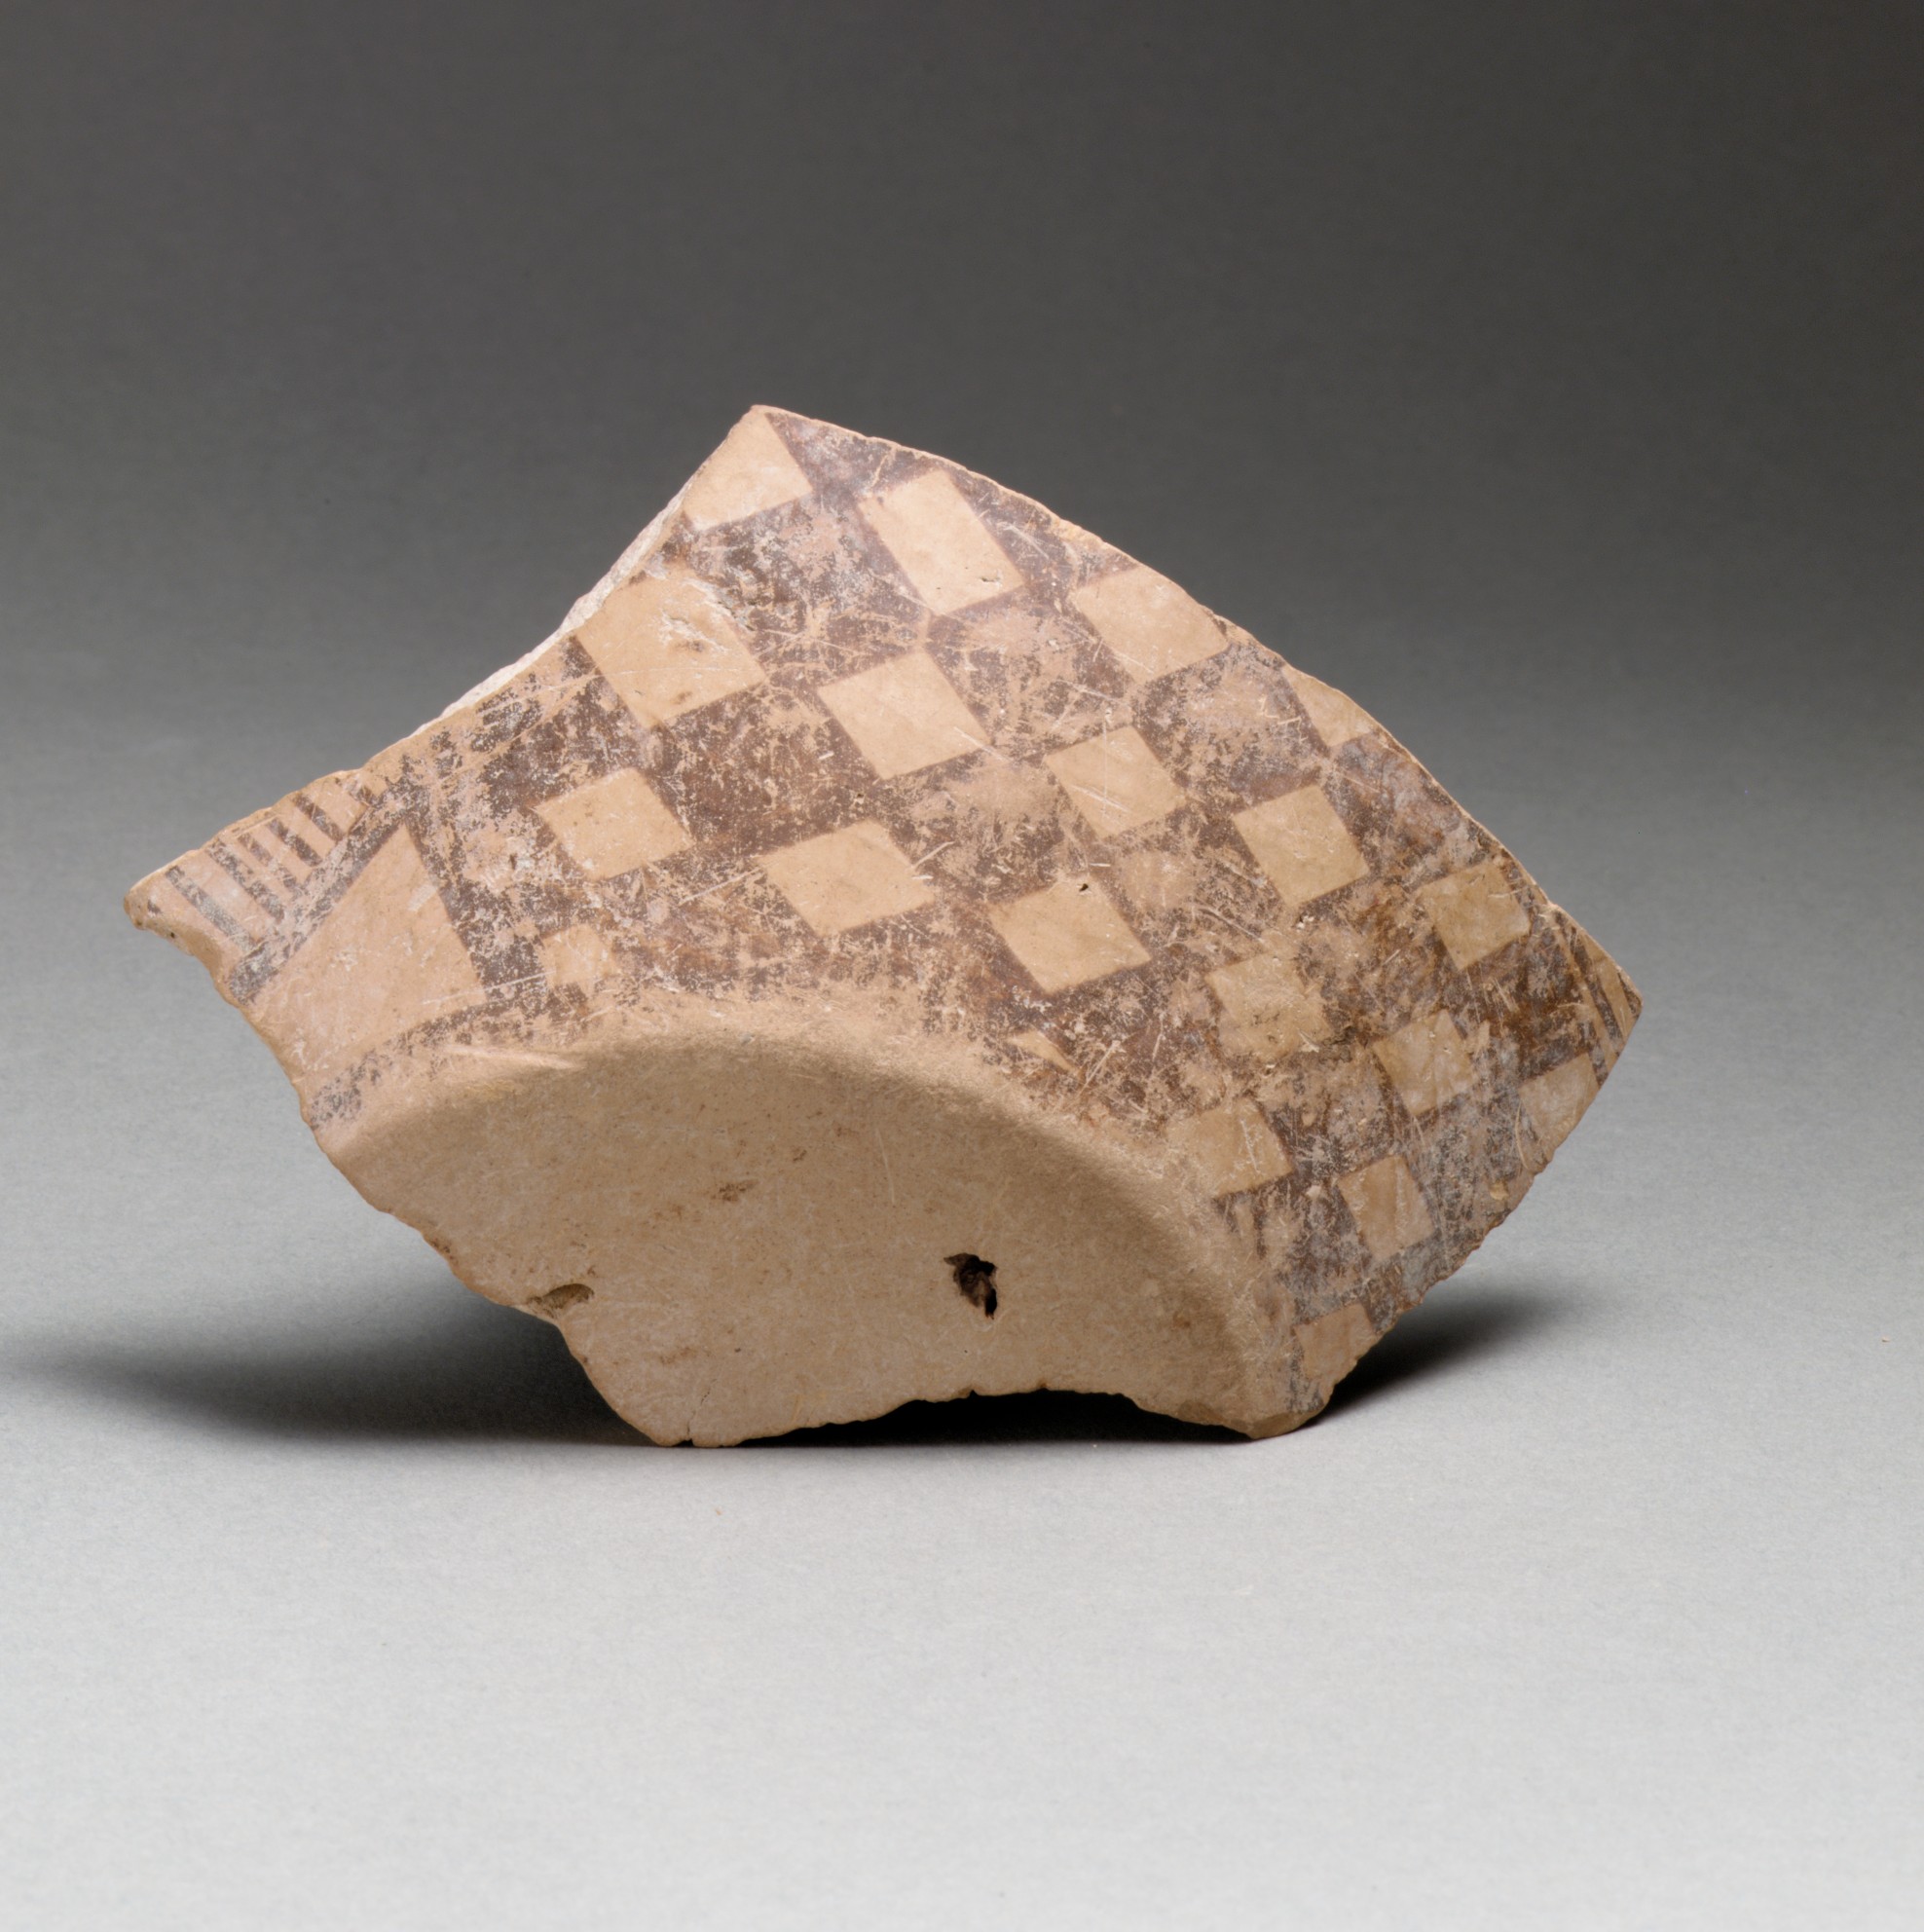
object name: vase fragment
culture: neolithic, thessaly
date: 4000-3000 BCE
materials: terracotta